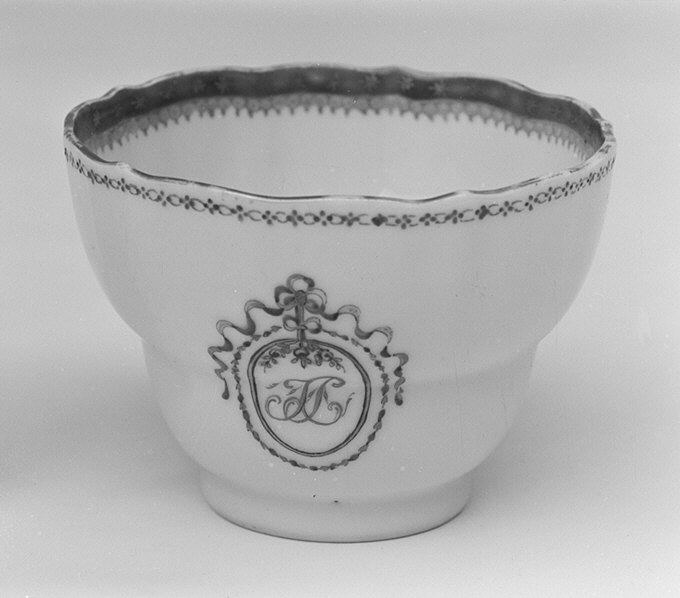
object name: cup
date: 1785-1800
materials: hard paste porcelain